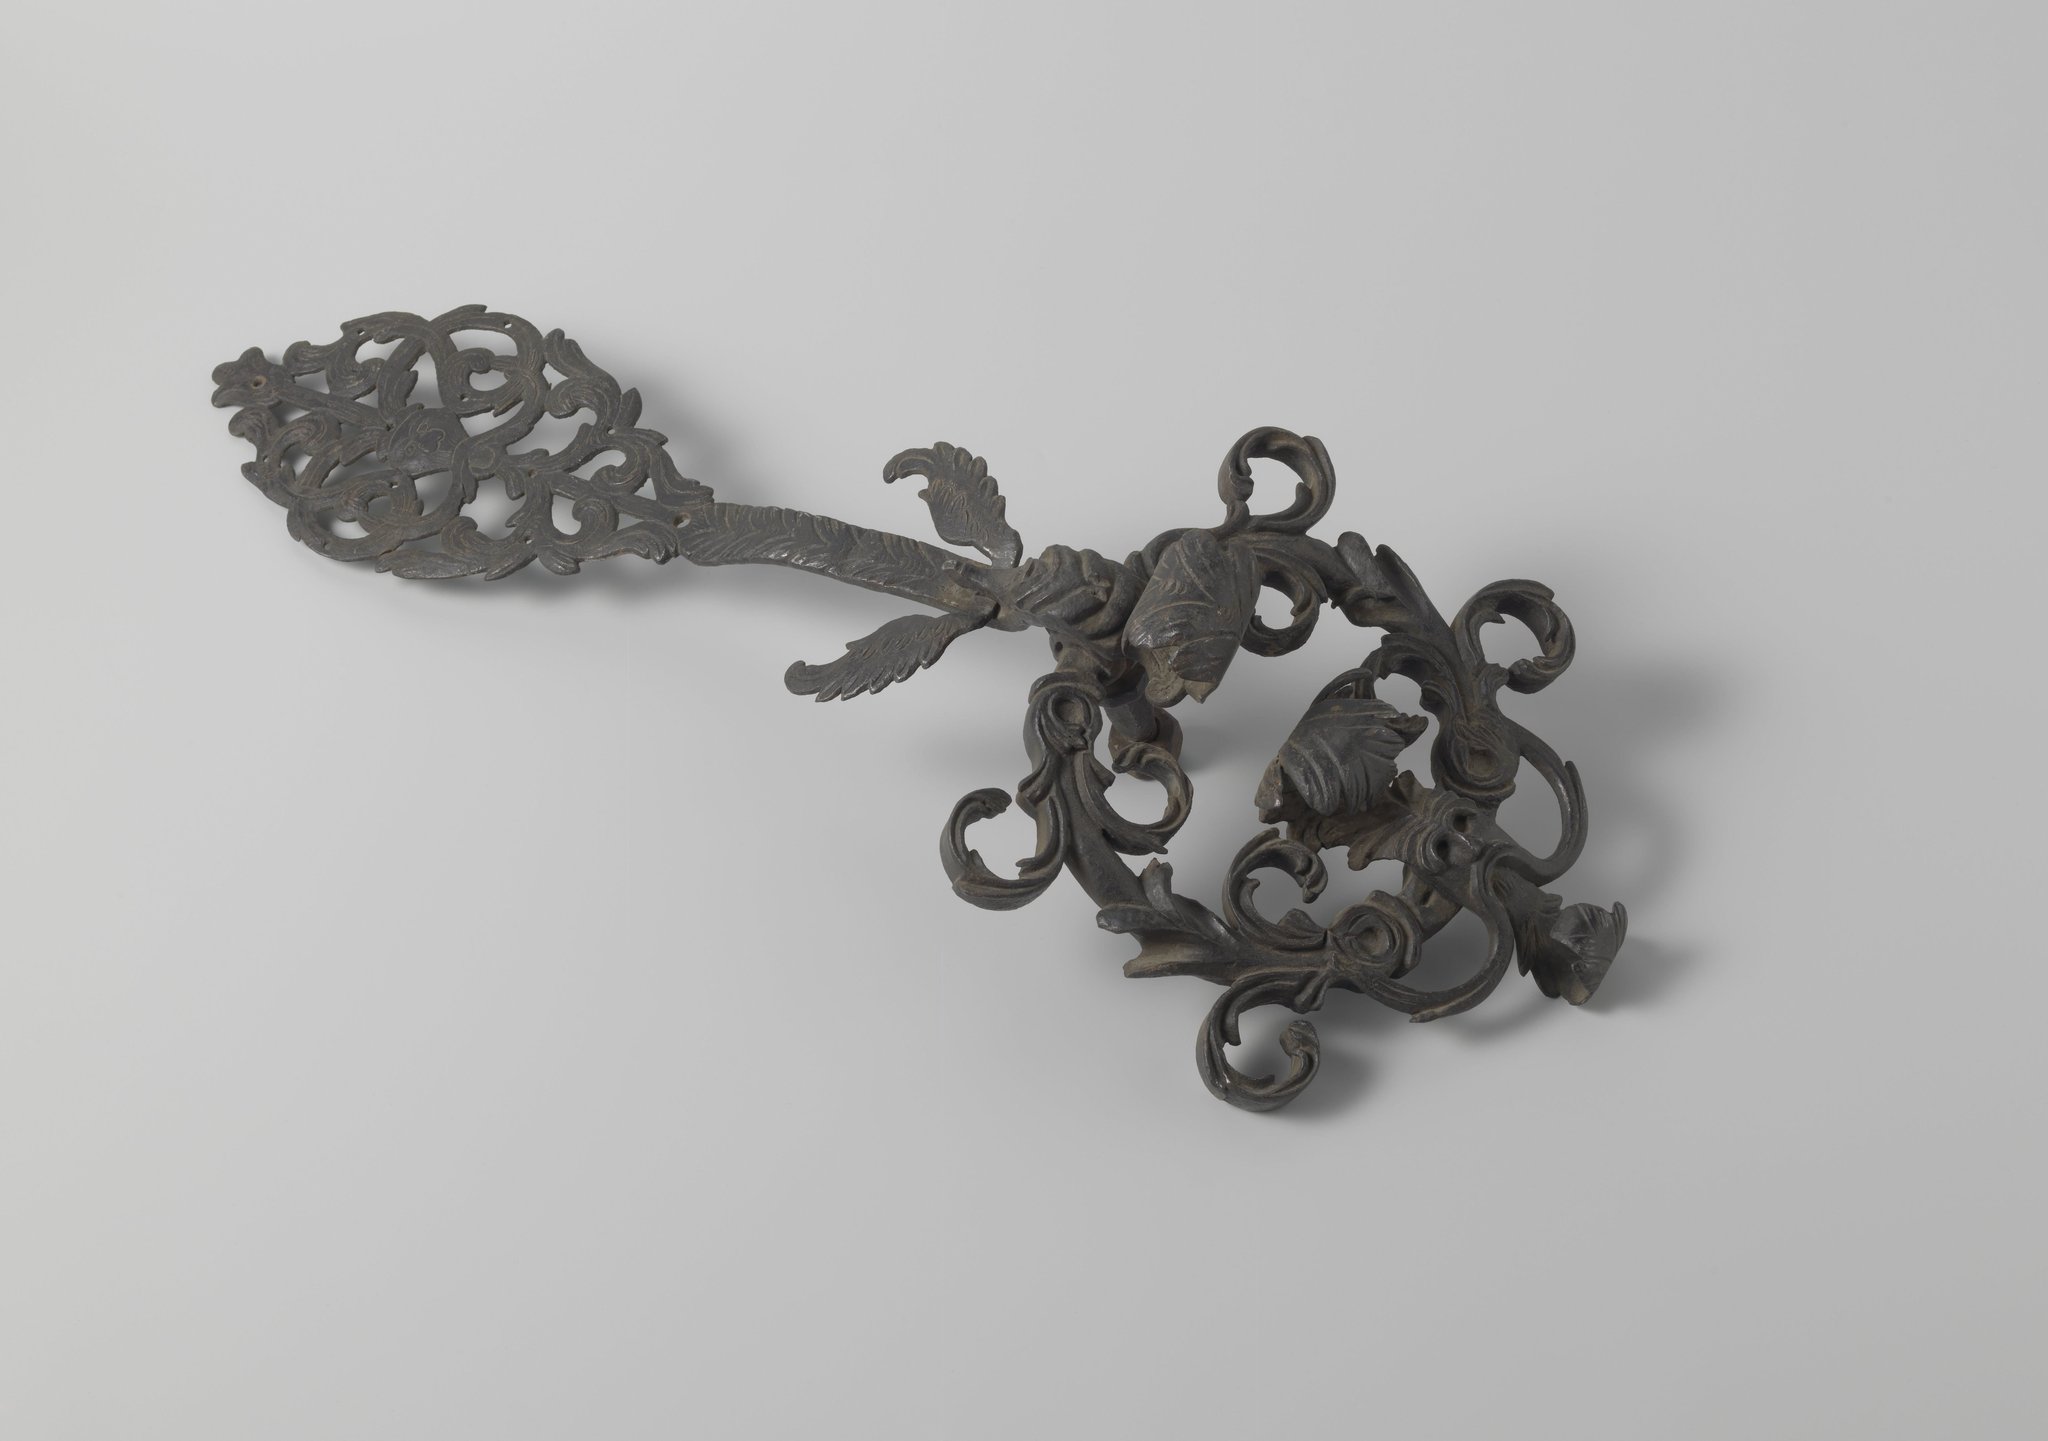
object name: door knocker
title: Deurklopper, versierd met mannenkop en pelikaan (of arend)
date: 1550-1600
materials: iron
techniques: casting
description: Een gegoten en opgewerkte ijzeren deurklopper. De ring met rijke ornamenten, bladerenm waarvan er enige een mannenkop vormen. De deurplaat eveneens, eindigende in een pelikaan of arend.